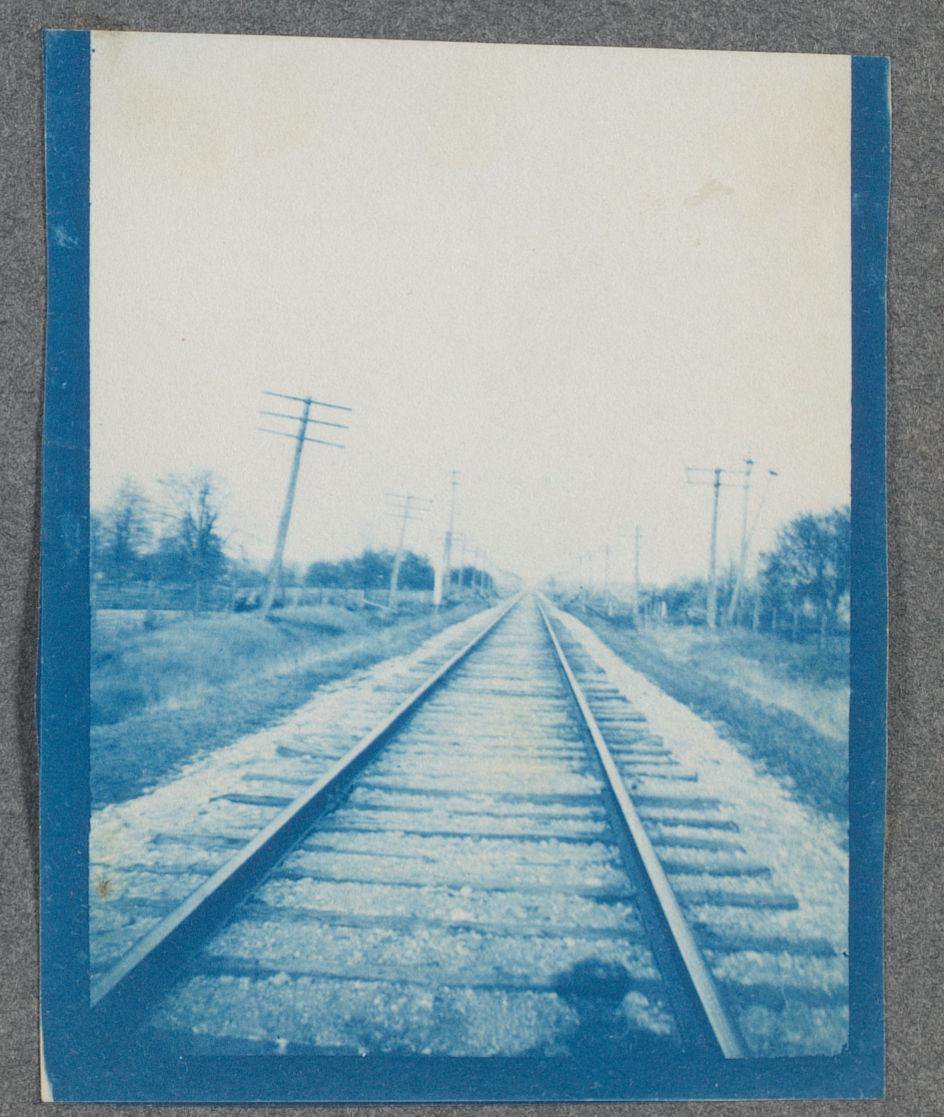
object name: photograph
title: Treinspoor, onderin de schaduw van de fotograaf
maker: Anonymous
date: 1905-1915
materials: paper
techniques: cyanotype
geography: united states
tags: taking photographs - cc - out of doors, united states of america